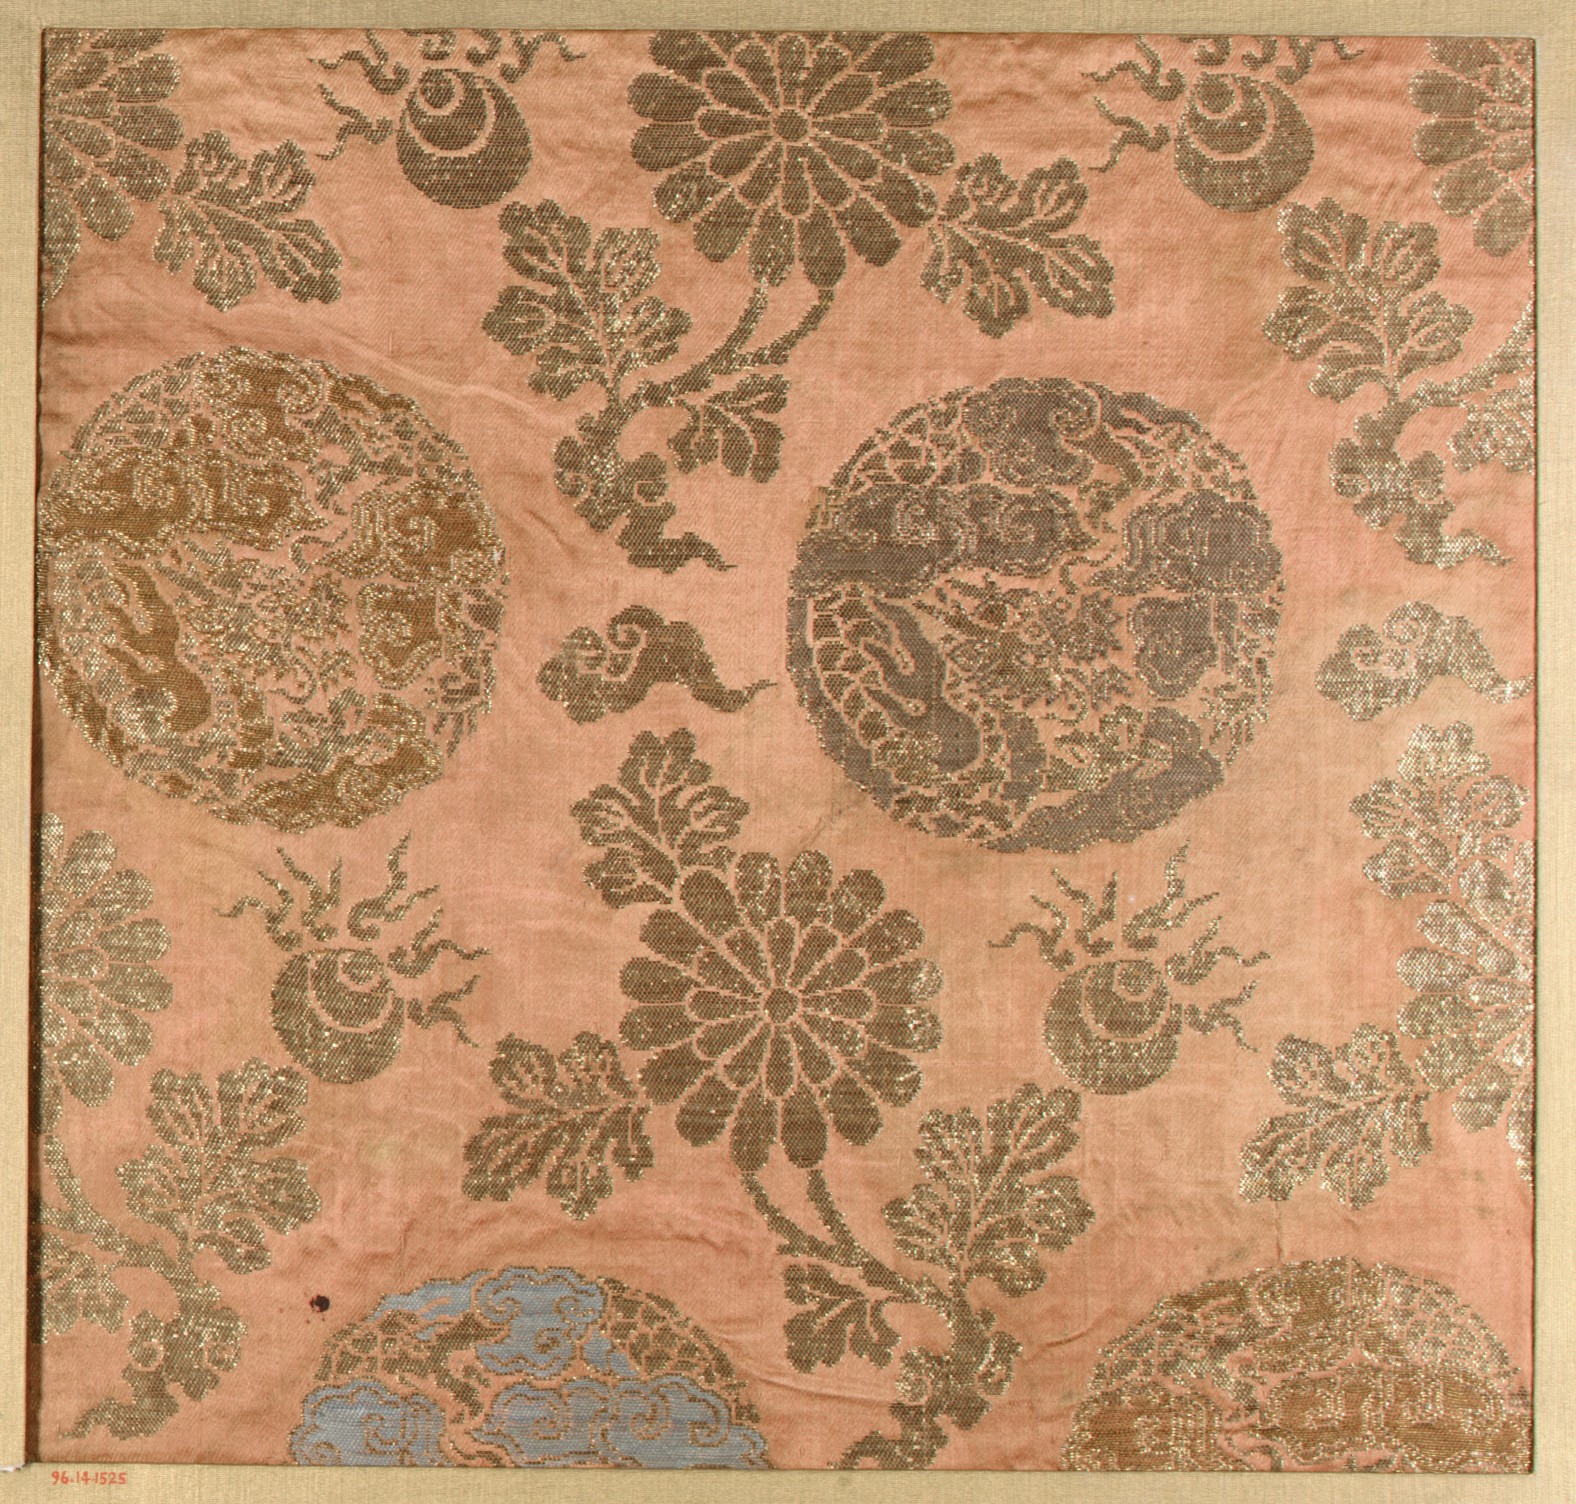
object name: piece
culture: japanese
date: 1701-1900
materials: silk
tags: leaves